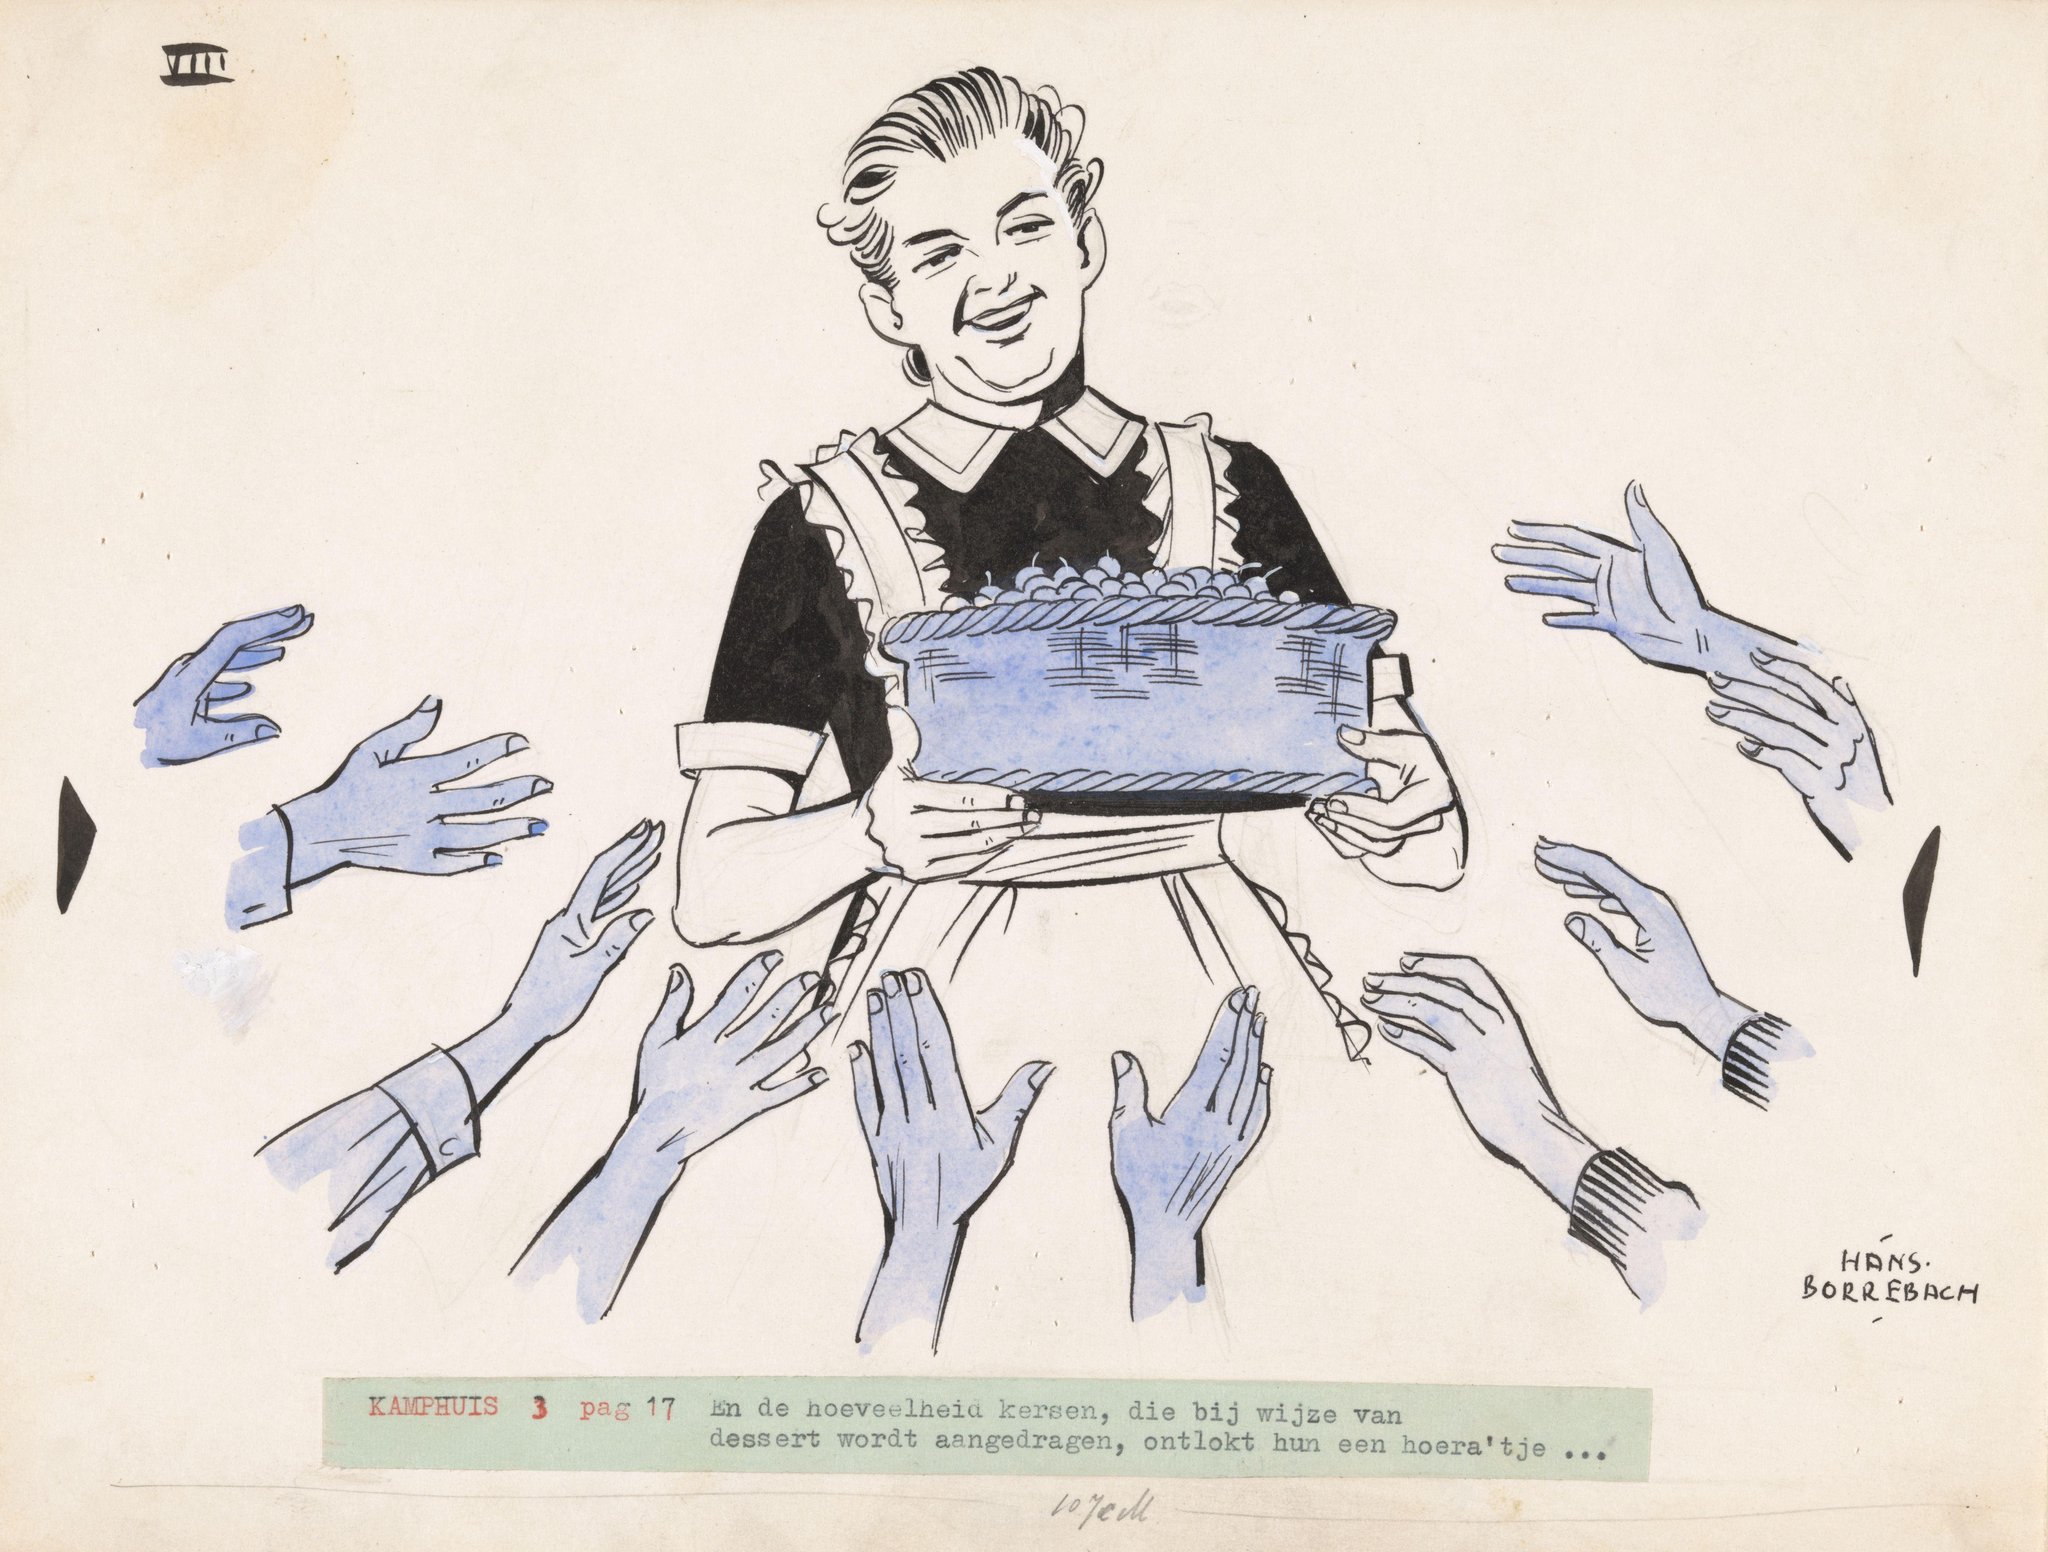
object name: drawing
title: Handen reikend naar een mand met kersen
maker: hans borrebach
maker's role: draughtsman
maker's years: 1903-1991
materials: paint, ink, paper, pencil, watercolor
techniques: brush, pen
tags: hand, apron, fruits: cherry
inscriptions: collector's mark: Lugt 2228a, number: ‘IIII’, :, signature: ‘HANS./ BORREBACH’, annotation: ‘KAMPHUIS 3 pag 17 En de hoeveelheid kersen, die bij wijze van/ dessert wordt aangedragen, ontlokt hun een hoera'tje ...’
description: Een vrouw gekleed in een jurk en schort houdt een mand met kersen in haar handen. Tien handen reiken naar de mand.